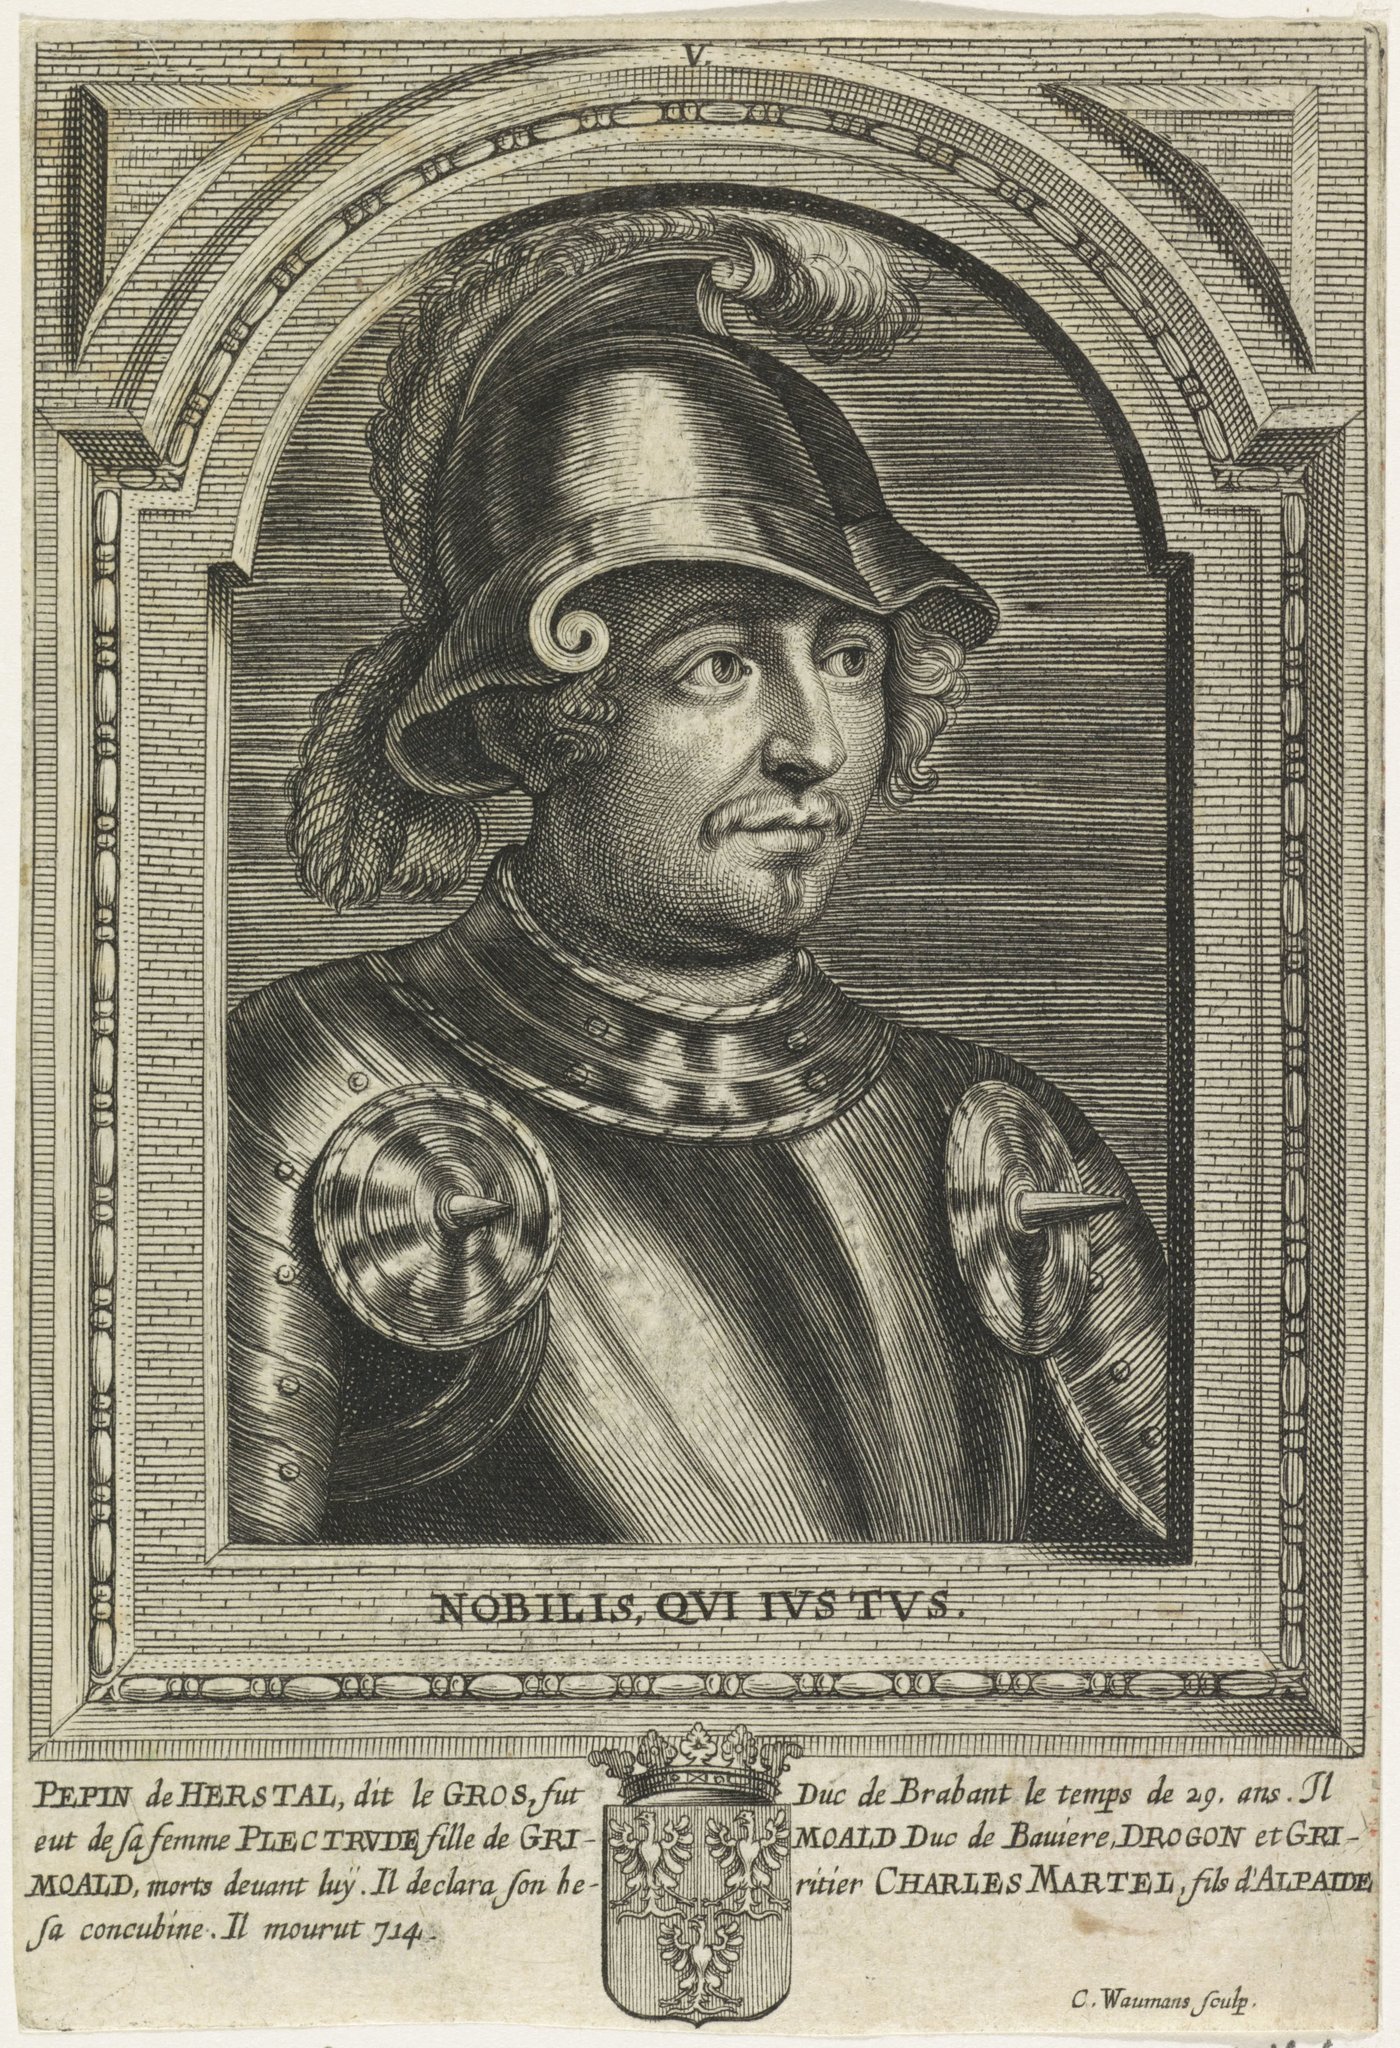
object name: print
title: Portret van Pepijn (II) van Herstal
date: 1662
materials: paper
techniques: engraving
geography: antwerp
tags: armour, armorial bearing, heraldry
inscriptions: collector's mark: Lugt 240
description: Prent gebruikt in: Meyssens, C. Les pourtraits des souverains princes et comtes de Hollande. Antwerpen: J. Meyssens, 1662. Op de frontispiece wordt Richard Collin specifiek genoemd als graveur van de wapenschilden op de prenten in deze uitgave.